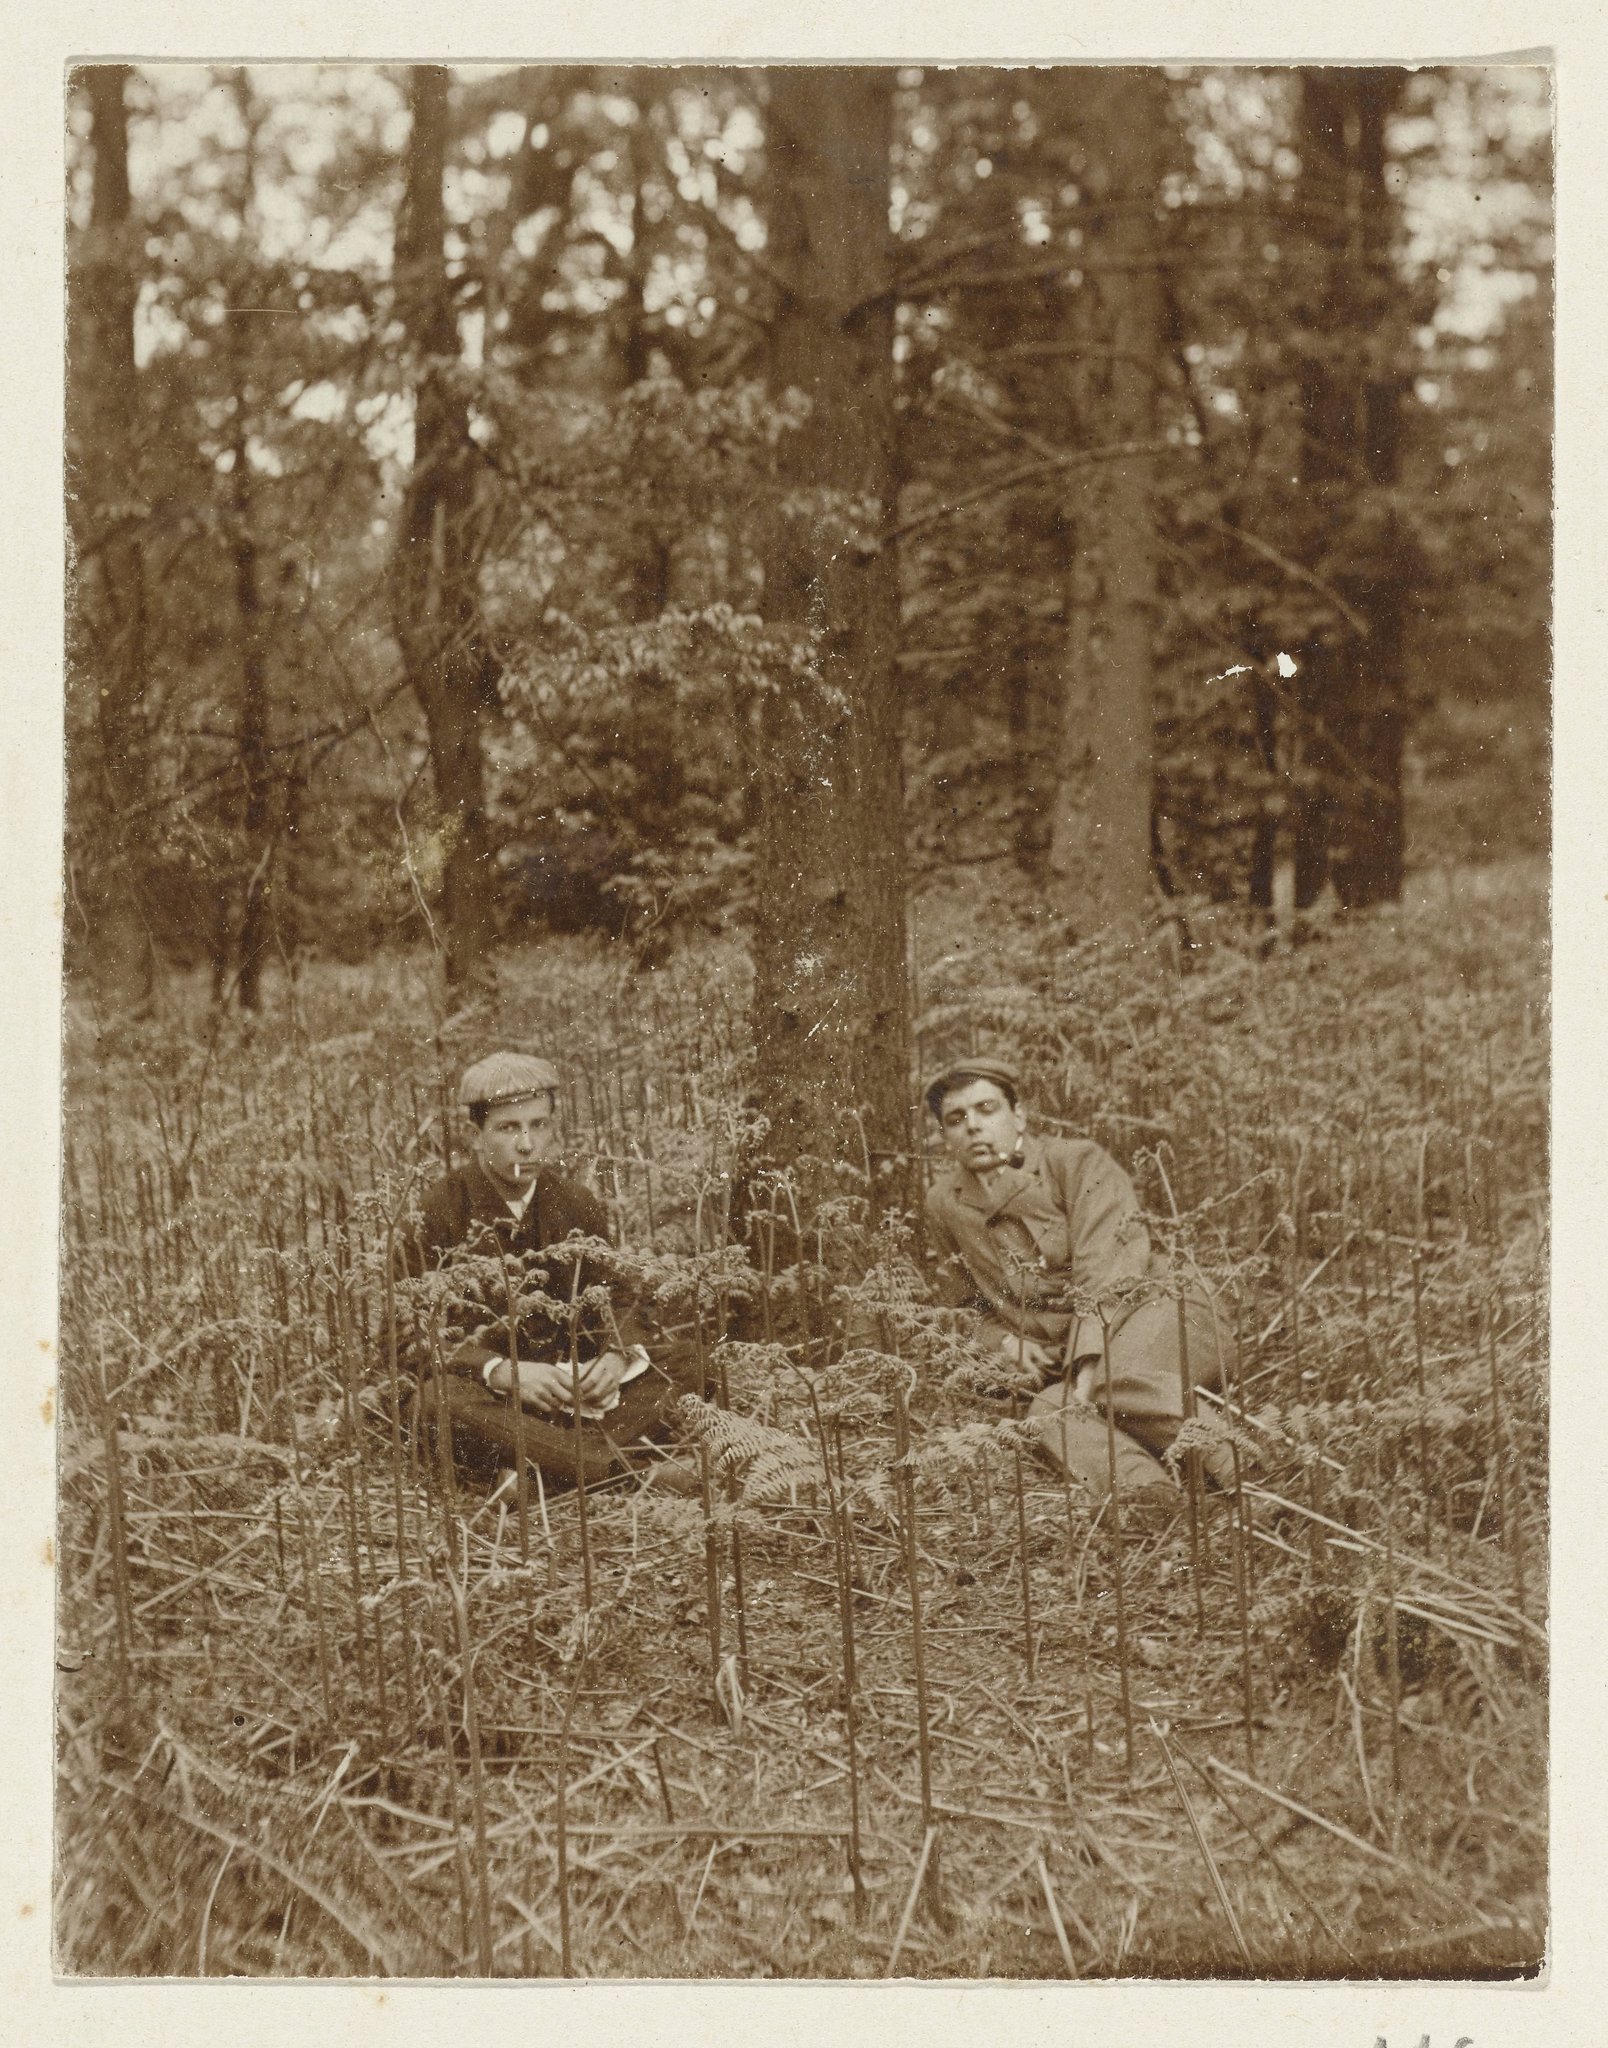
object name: photograph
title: Dolph Kessler met een vriend in het bos bij Gainsborough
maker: geldolph adriaan kessler (dolph)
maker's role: fotograaf, industrieel, voetballer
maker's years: 1884-1945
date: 1903-1904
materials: cardboard, photographic support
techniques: gelatin silver print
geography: gainsborough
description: Dolph Kessler met een vriend in het bos bij vermoedelijk Gainsborough. Onderdeel van het fotoalbum van Dolph Kessler met opnamen die hij maakte tijdens zijn verblijf in Engeland en op een wereldreis die hij als secretaris van Henri Deterding (directeur Koninklijke Olie) ondernam naar Nederlands-Indië, Japan, China en de Verenigde Staten, tussen 1906 en 1908.